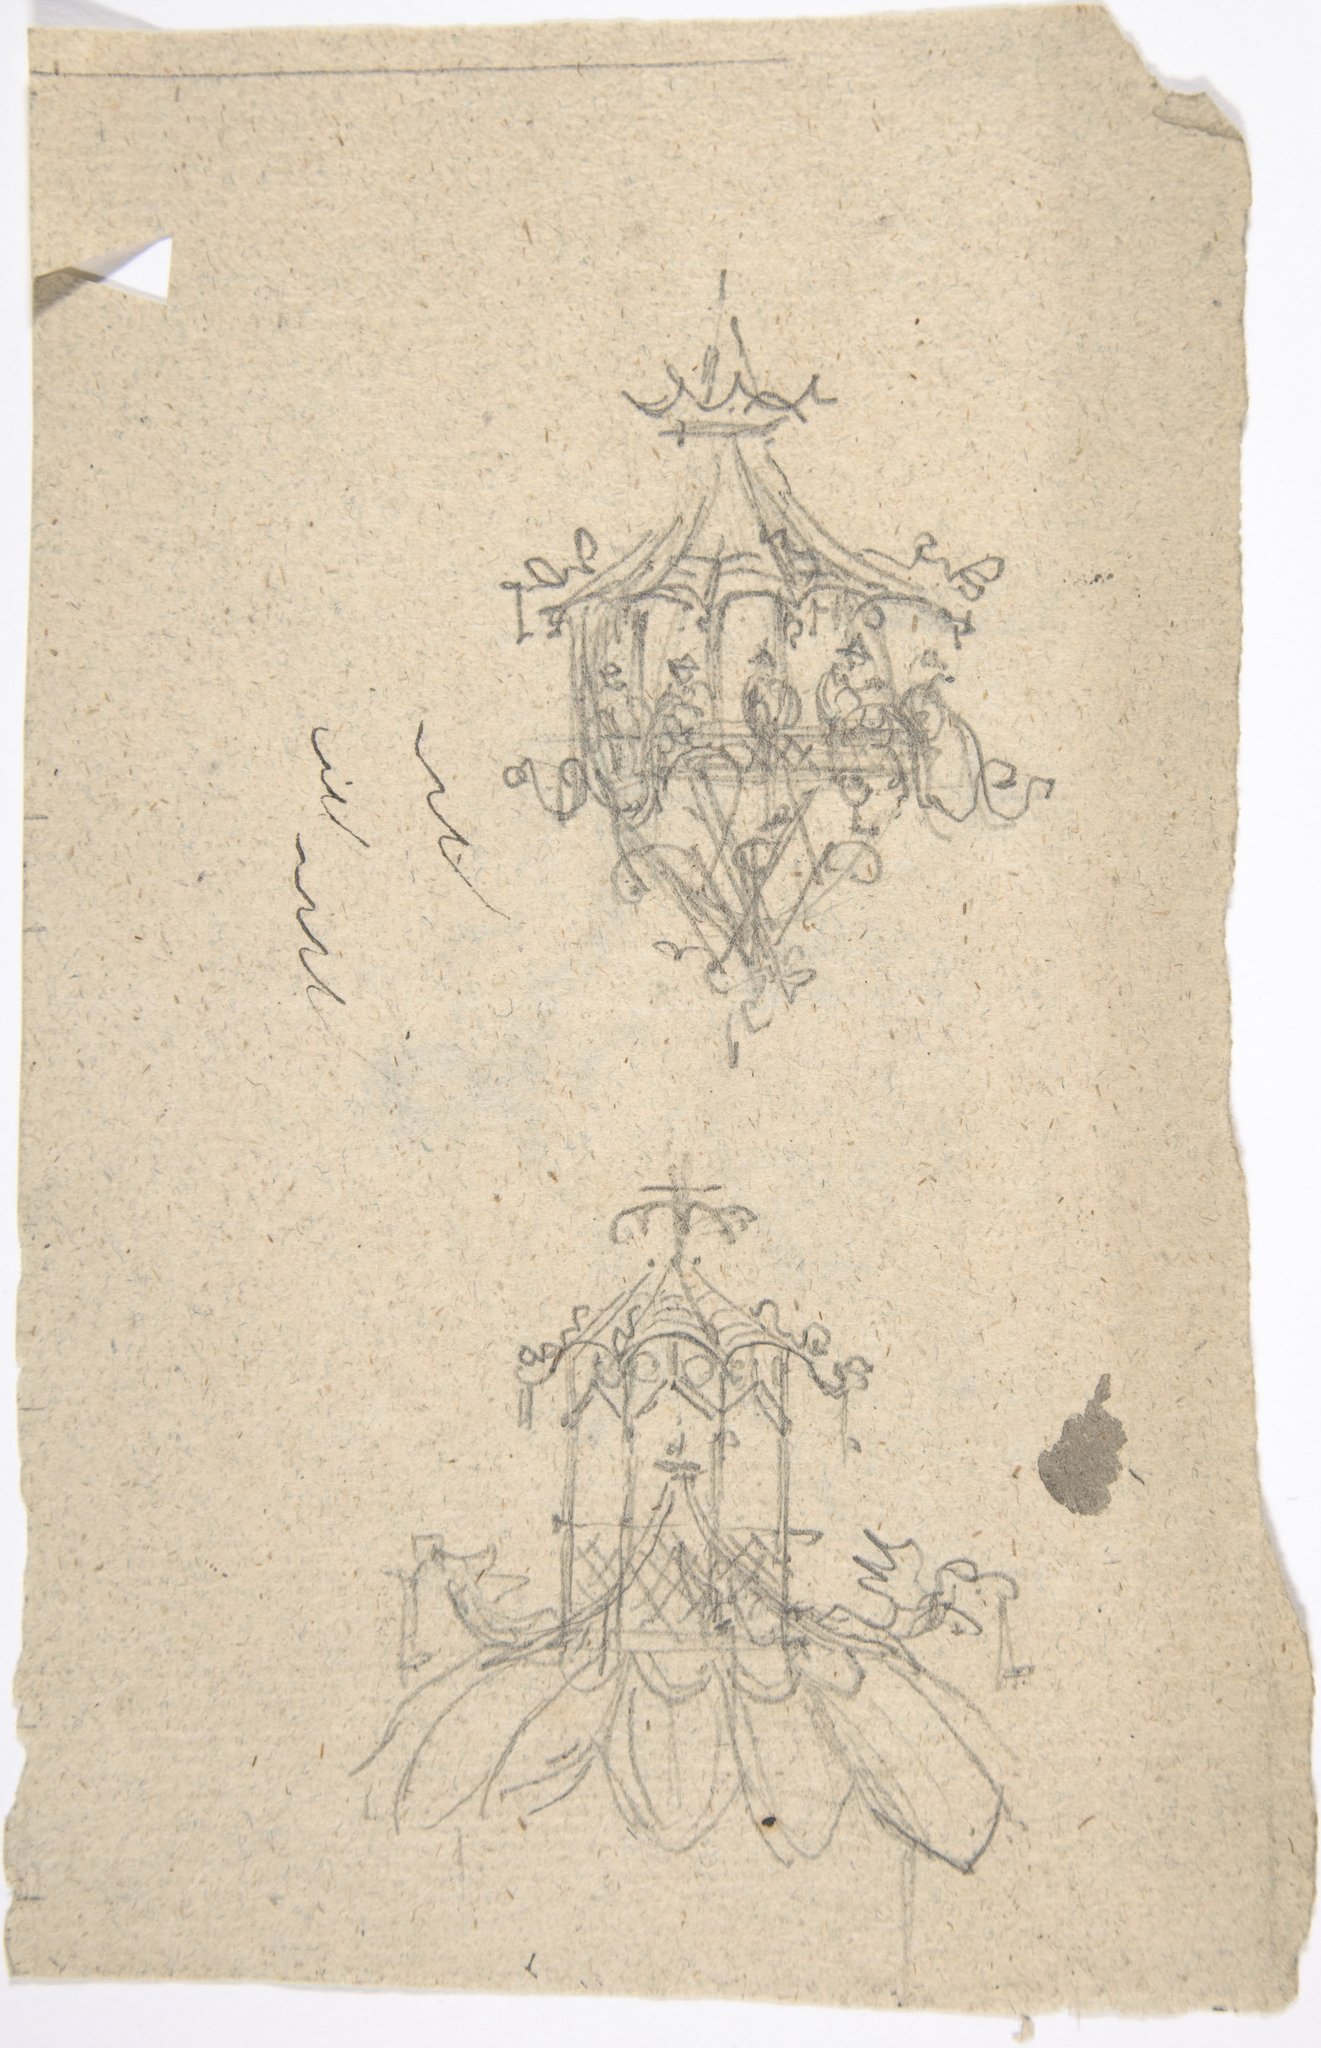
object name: ornament architecture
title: Two Designs for Chinese Lanterns (recto); Design for a Neoclassical Tomb or Monument with Sphinxes (verso)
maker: anonymous, french, 18th century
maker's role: artist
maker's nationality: french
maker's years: 1700-1800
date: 1768-1790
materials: graphite